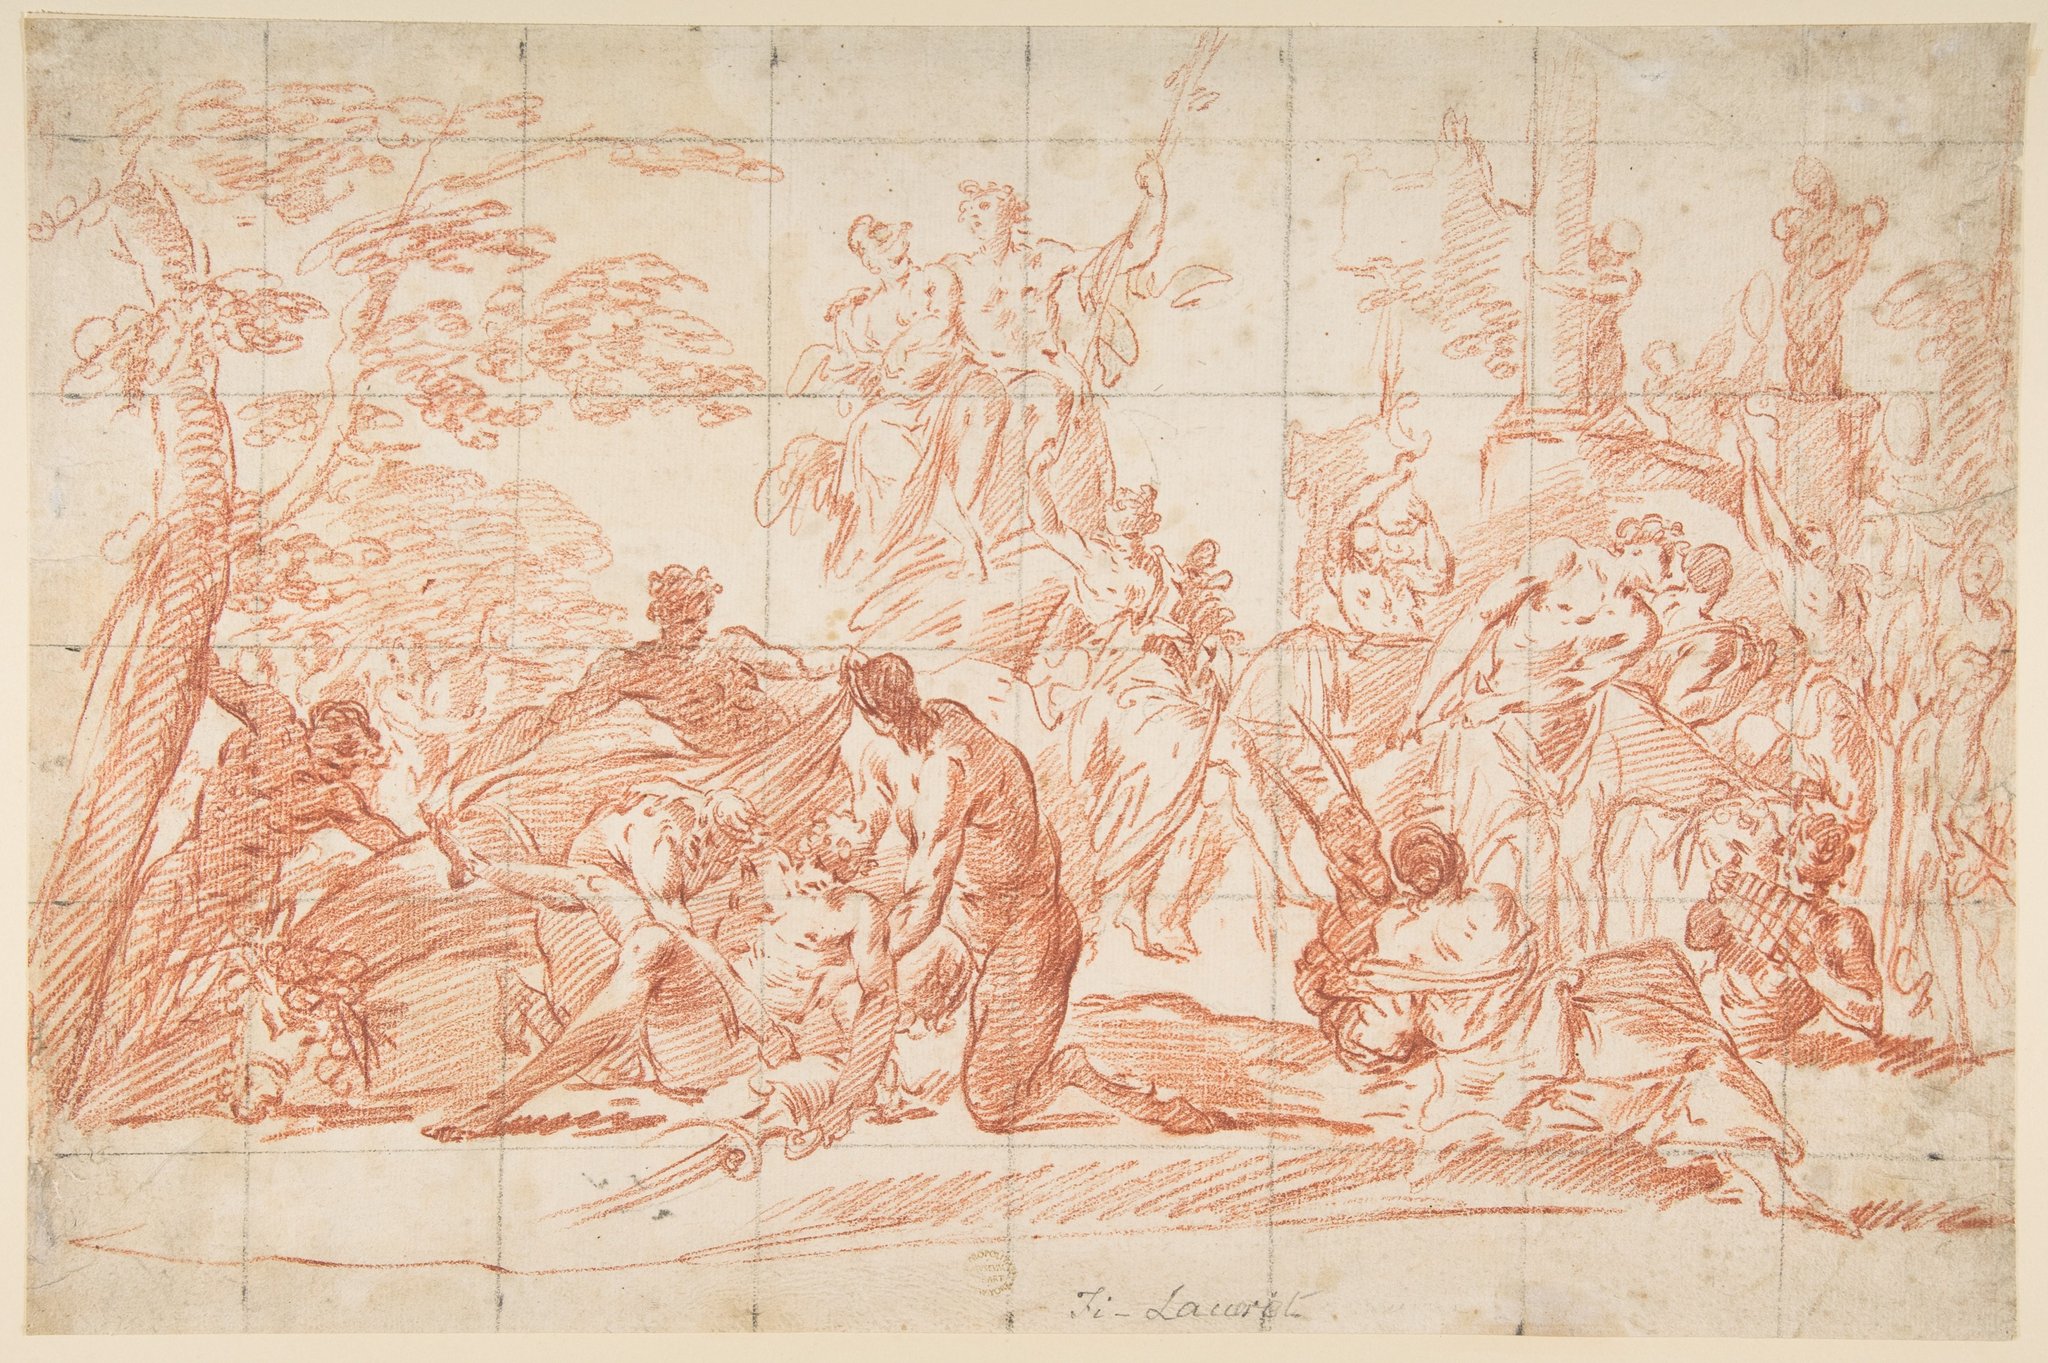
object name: drawing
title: Bacchanals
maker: anonymous, french, 18th century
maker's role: artist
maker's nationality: french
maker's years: 1700-1800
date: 1701-1800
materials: chalk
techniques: drawing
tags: men,women,party,trees